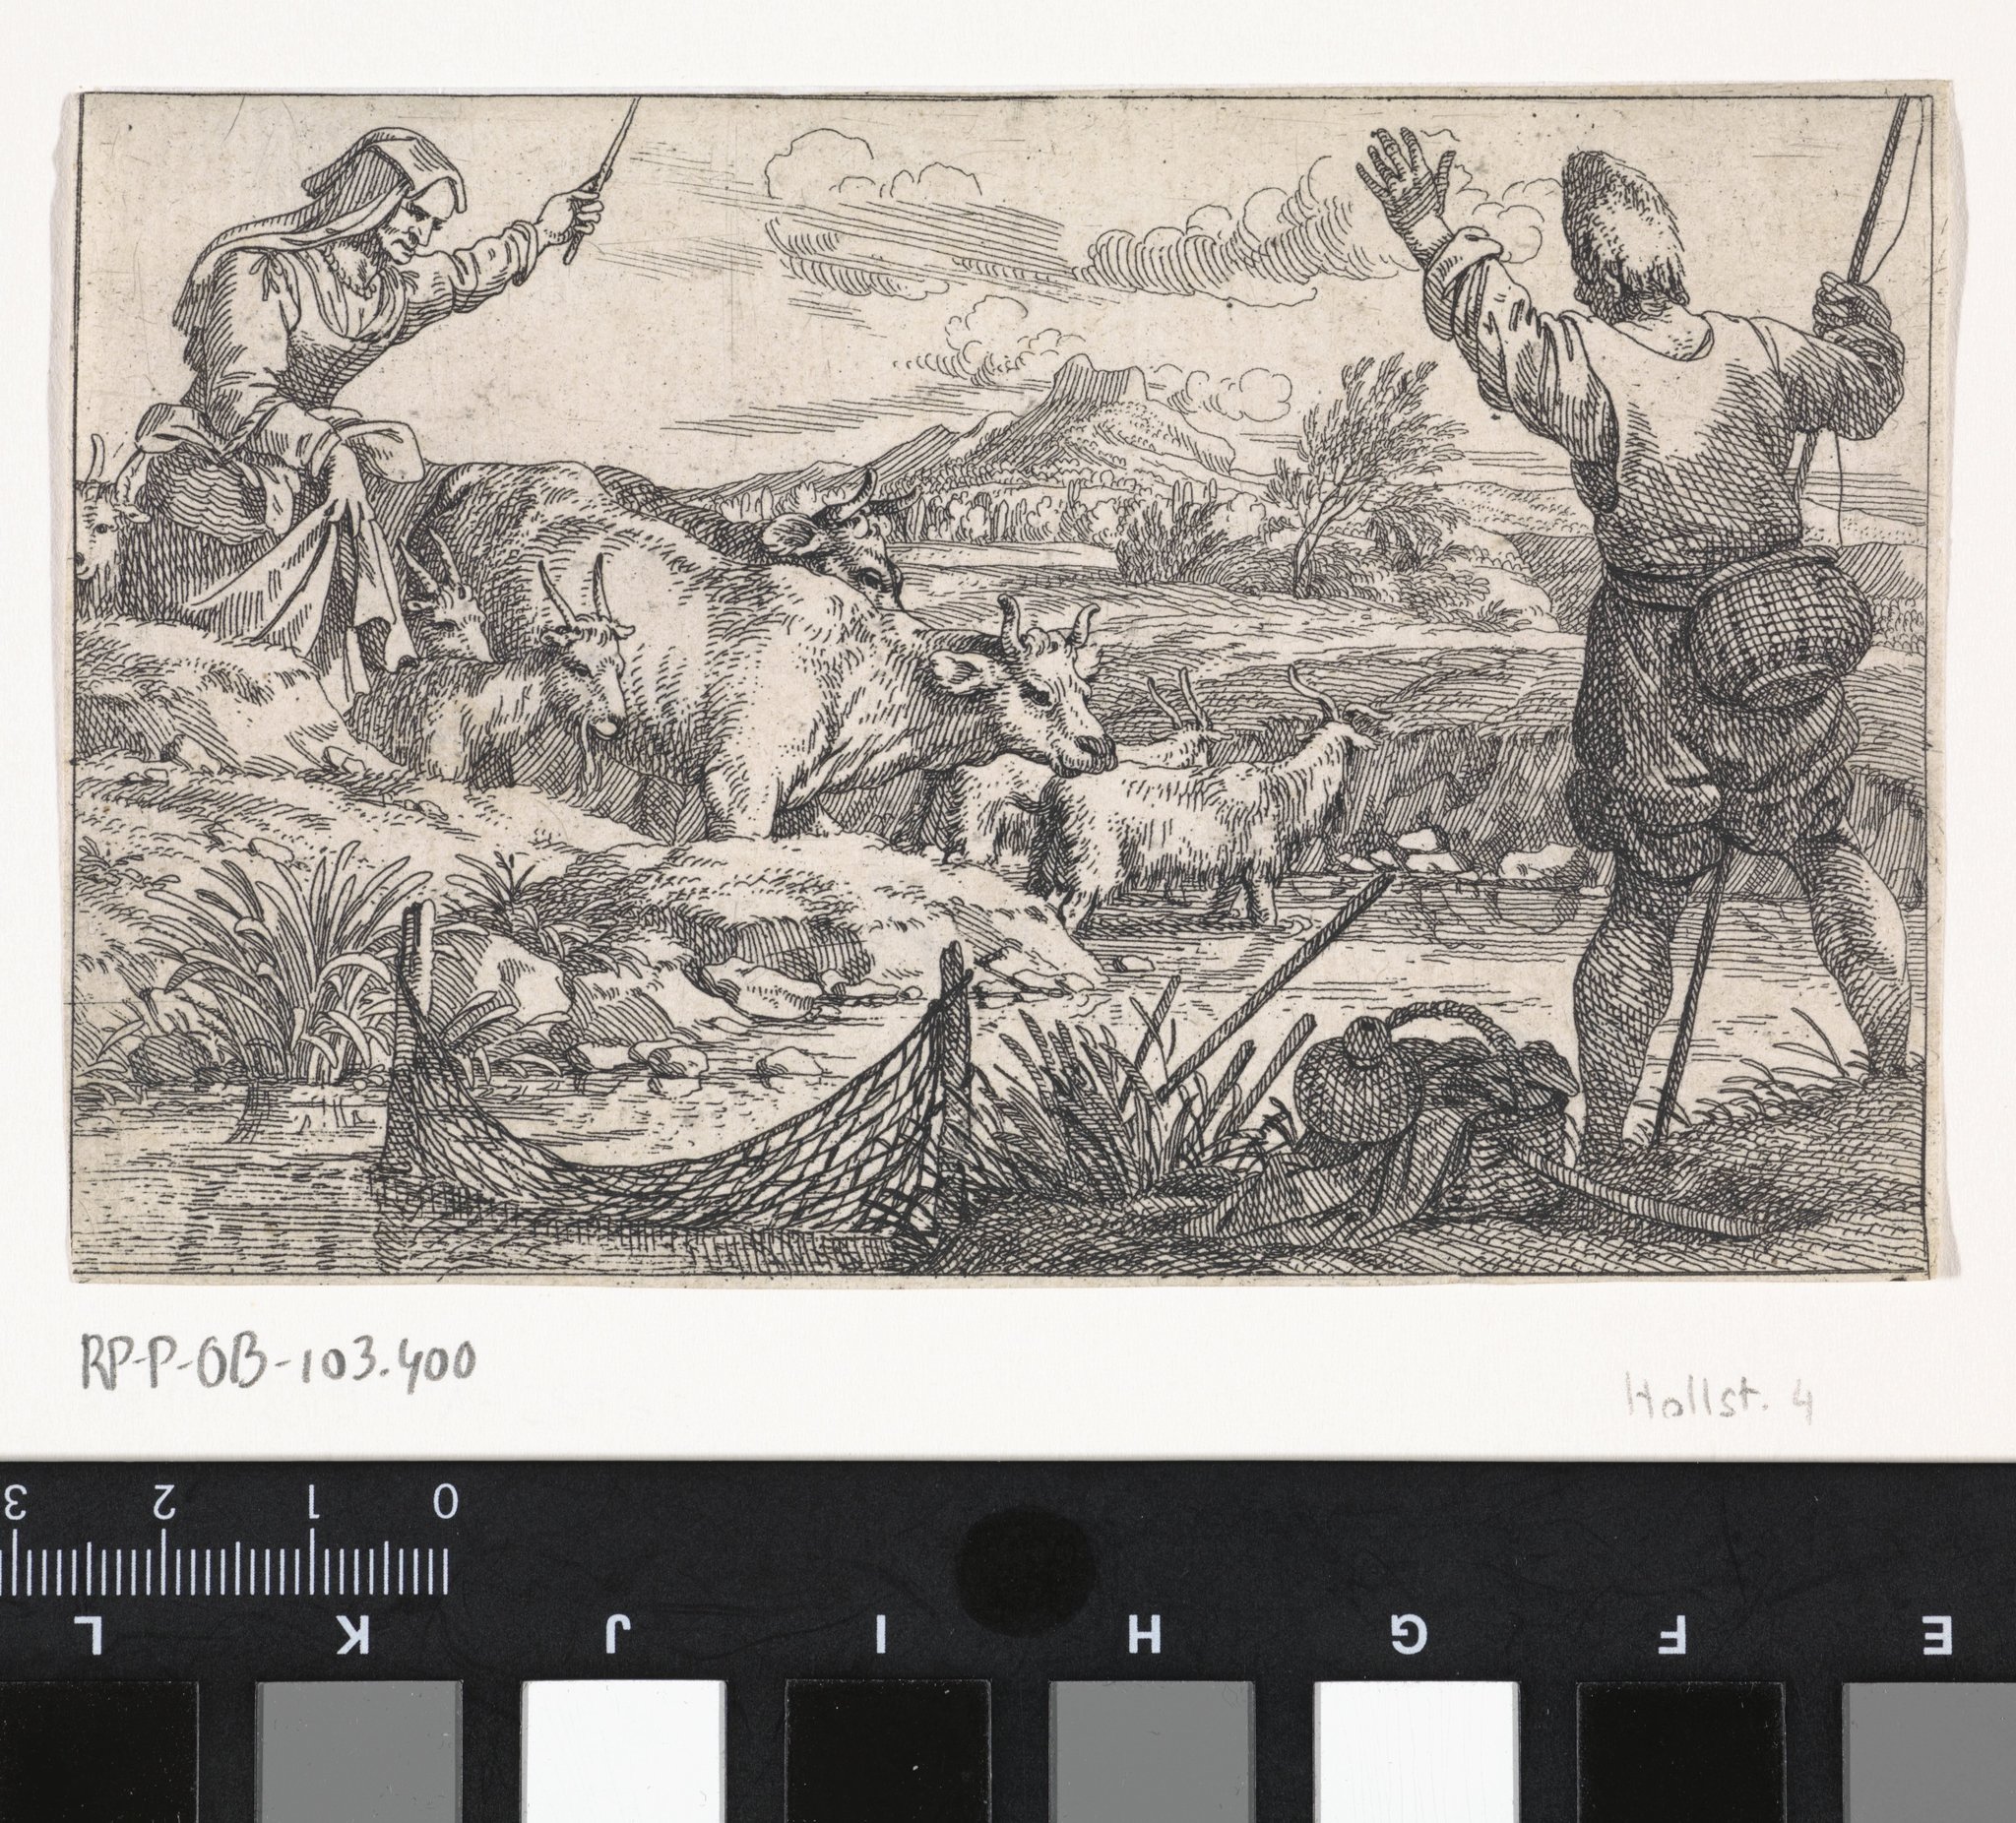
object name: print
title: Diverse genretaferelen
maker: jan baptist de wael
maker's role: print maker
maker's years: 1632-1669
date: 1642-1669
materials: paper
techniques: etching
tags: herd, flock, fisherman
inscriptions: collector's mark: Lugt 2228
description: Een visser staat op de oever van de rivier. In het water een net voor het vangen van vissen. Hij zwaait naar een vrouw die haar kudde voortdrijft door de rivier.